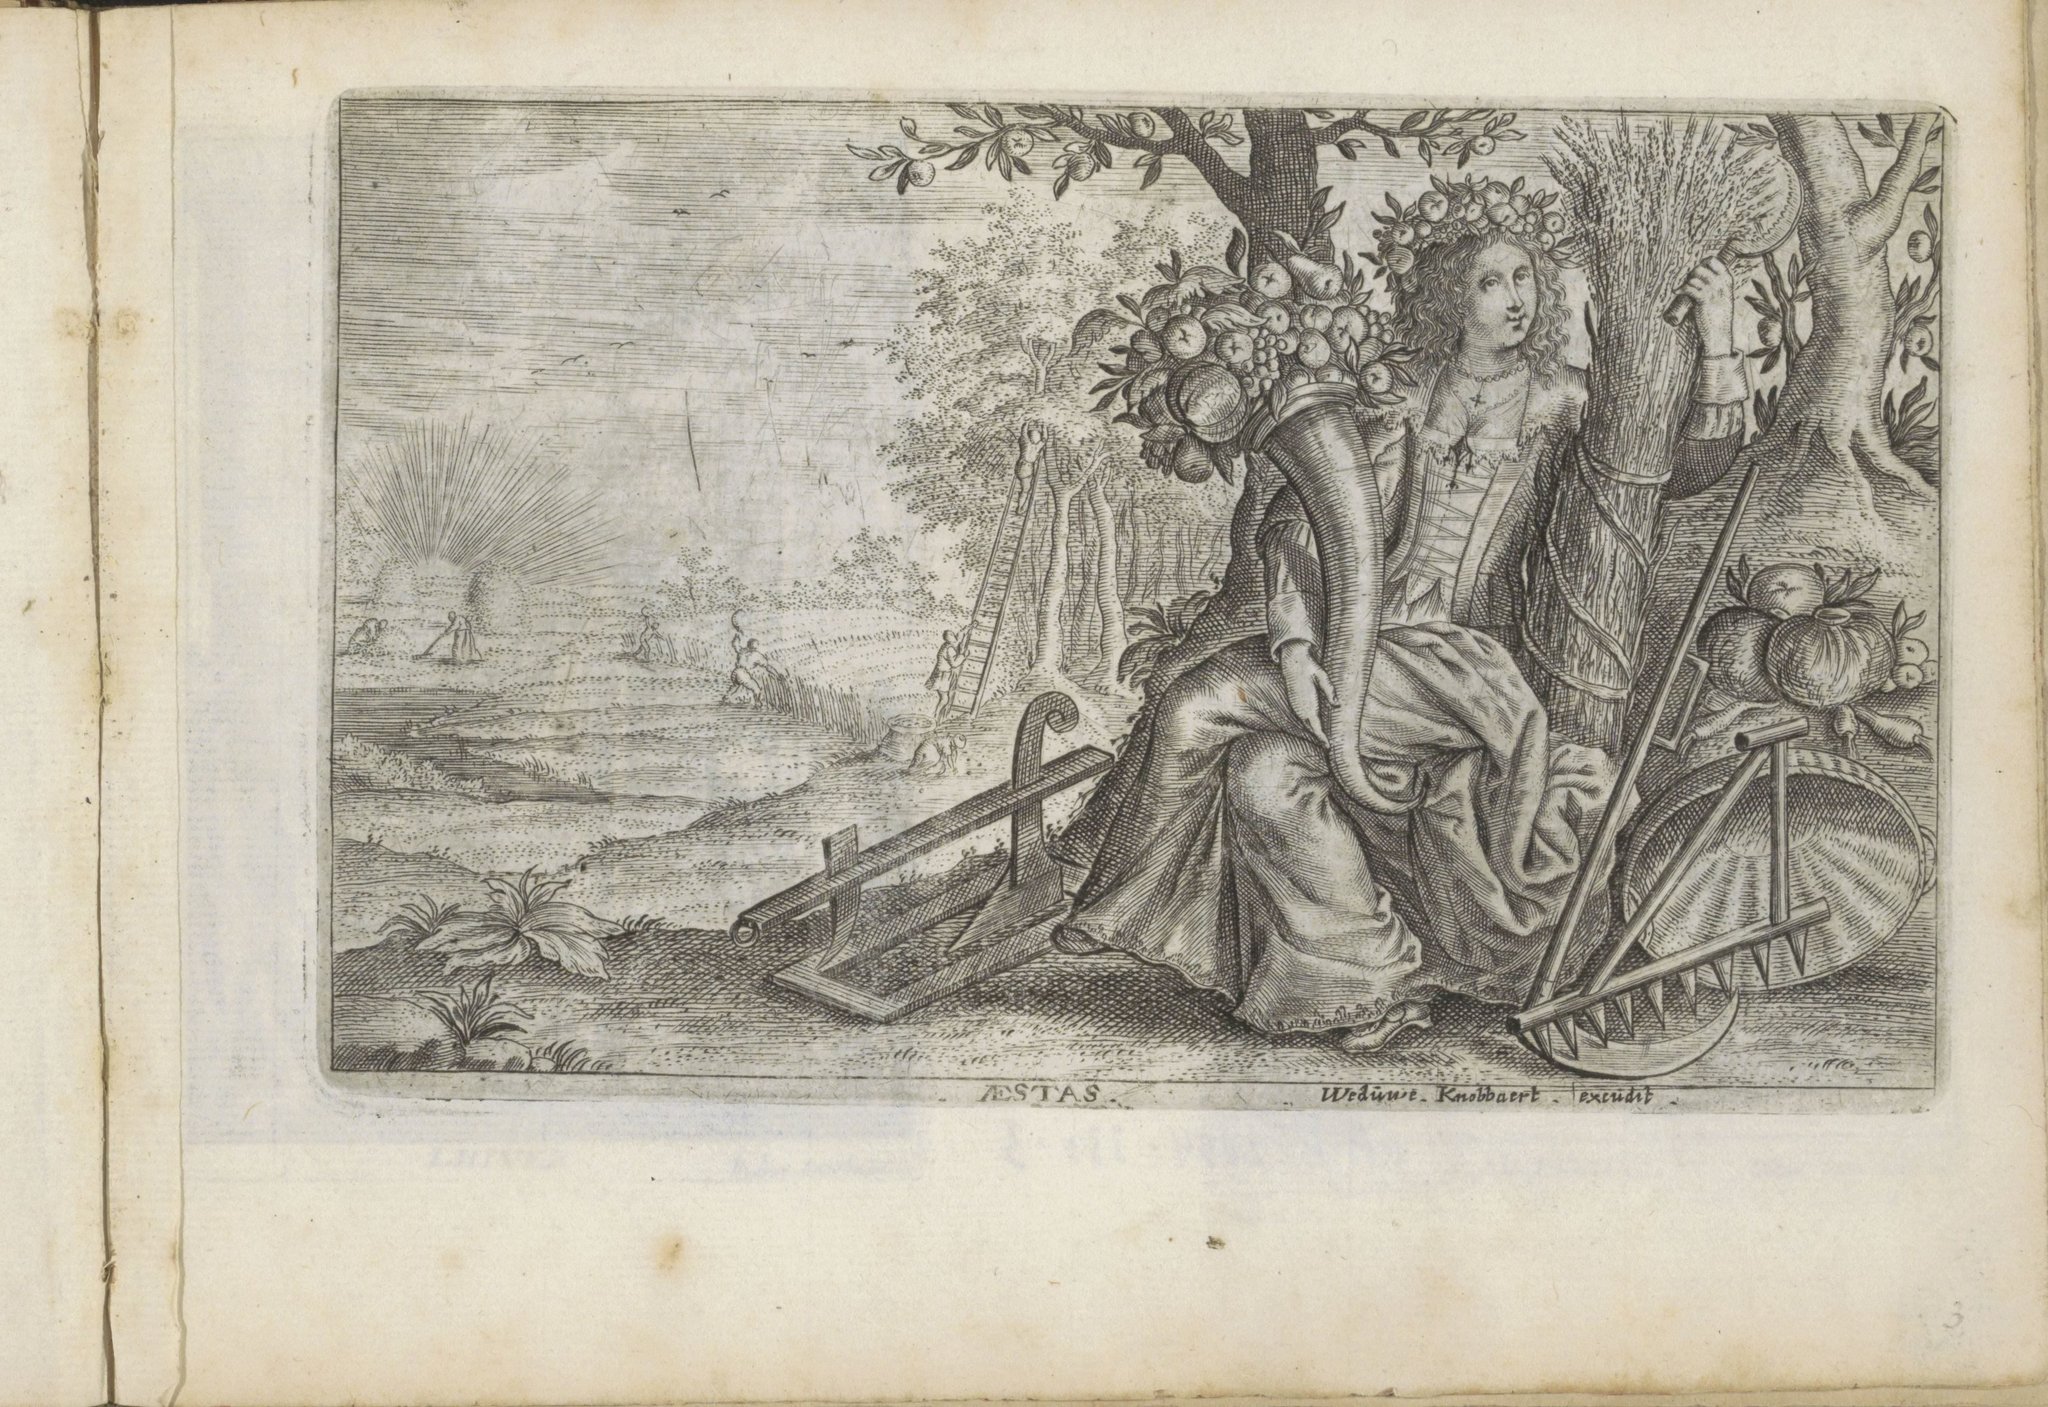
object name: print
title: De vier seizoenen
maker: maria cnobbaert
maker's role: publisher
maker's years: -1671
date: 1637-1671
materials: paper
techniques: engraving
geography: antwerp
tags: summer, 'aestas'; 'estate' (ripa), summer landscape; landscape symbolizing summer (the four seasons of the year) (+ with scenes showing human occupations ~ seasons and months)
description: De personificaties van de zomer zit onder bomen in een landschap met een hoorn des overvloeds en een korenschoof in haar armen. Naast haar liggen vruchten, een sikkel, een mand en ander gereedschap. Links een landschap waarin mensen graan oogsten en vruchten uit bomen plukken. Deze prent maakt deel uit van een album.